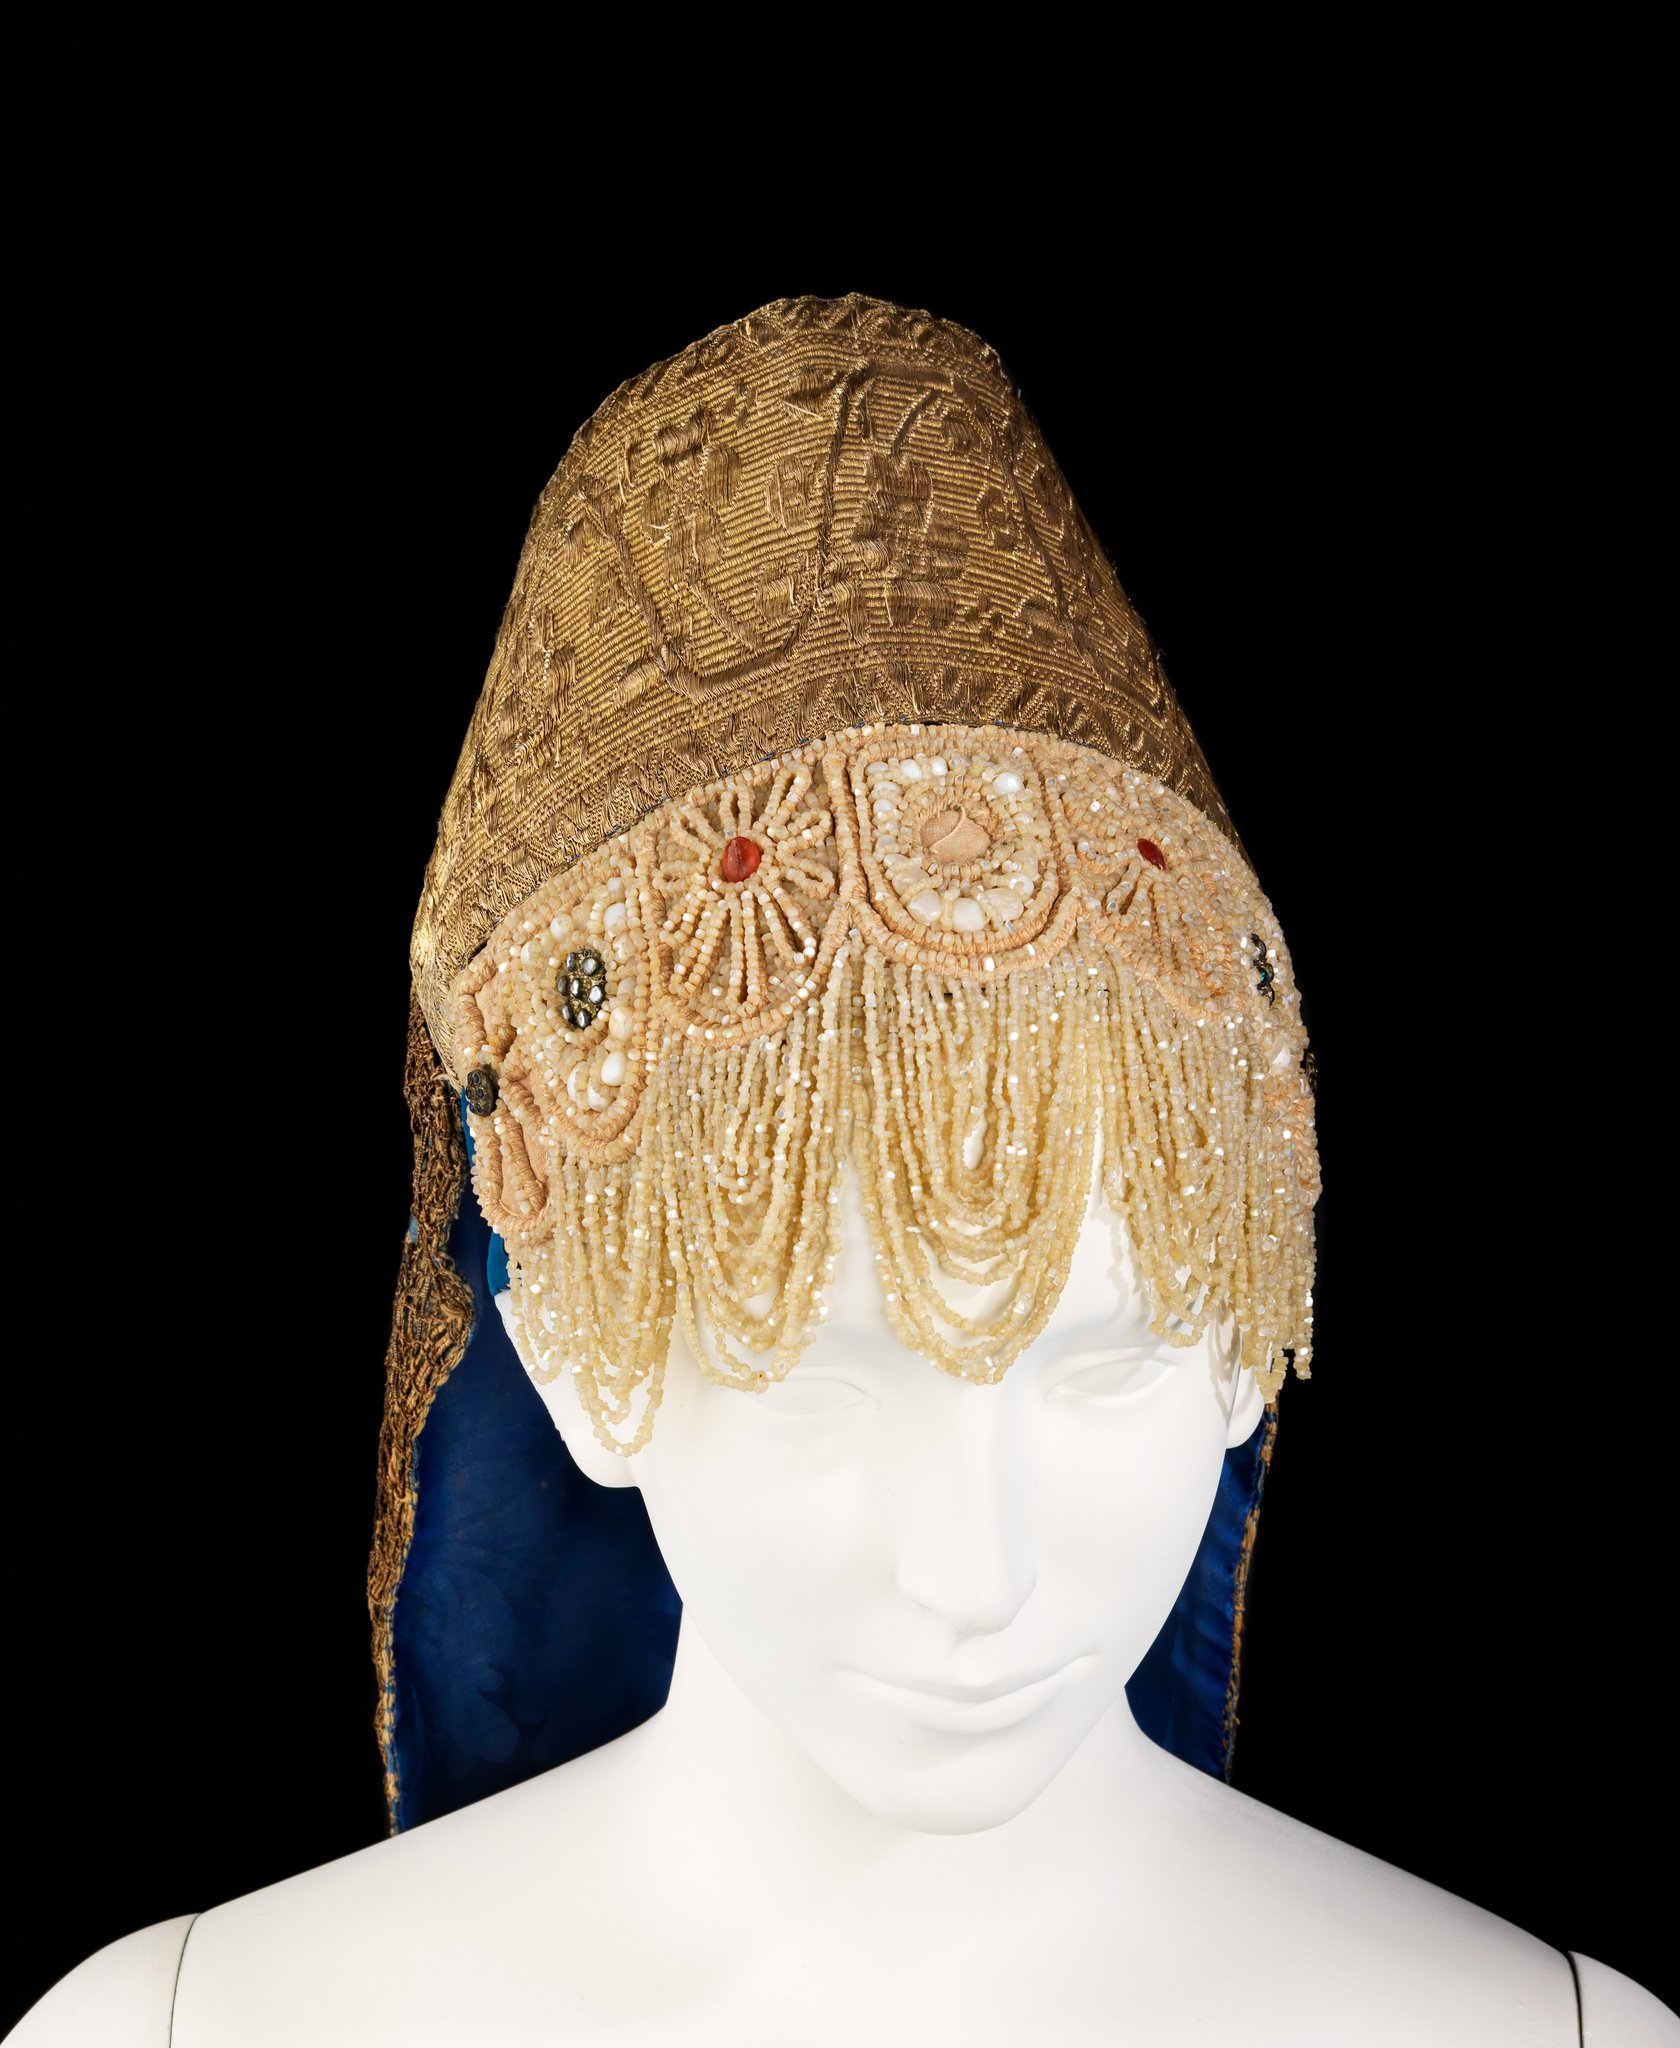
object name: headdress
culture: russian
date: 1801-1825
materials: glass, metal, shell, silk